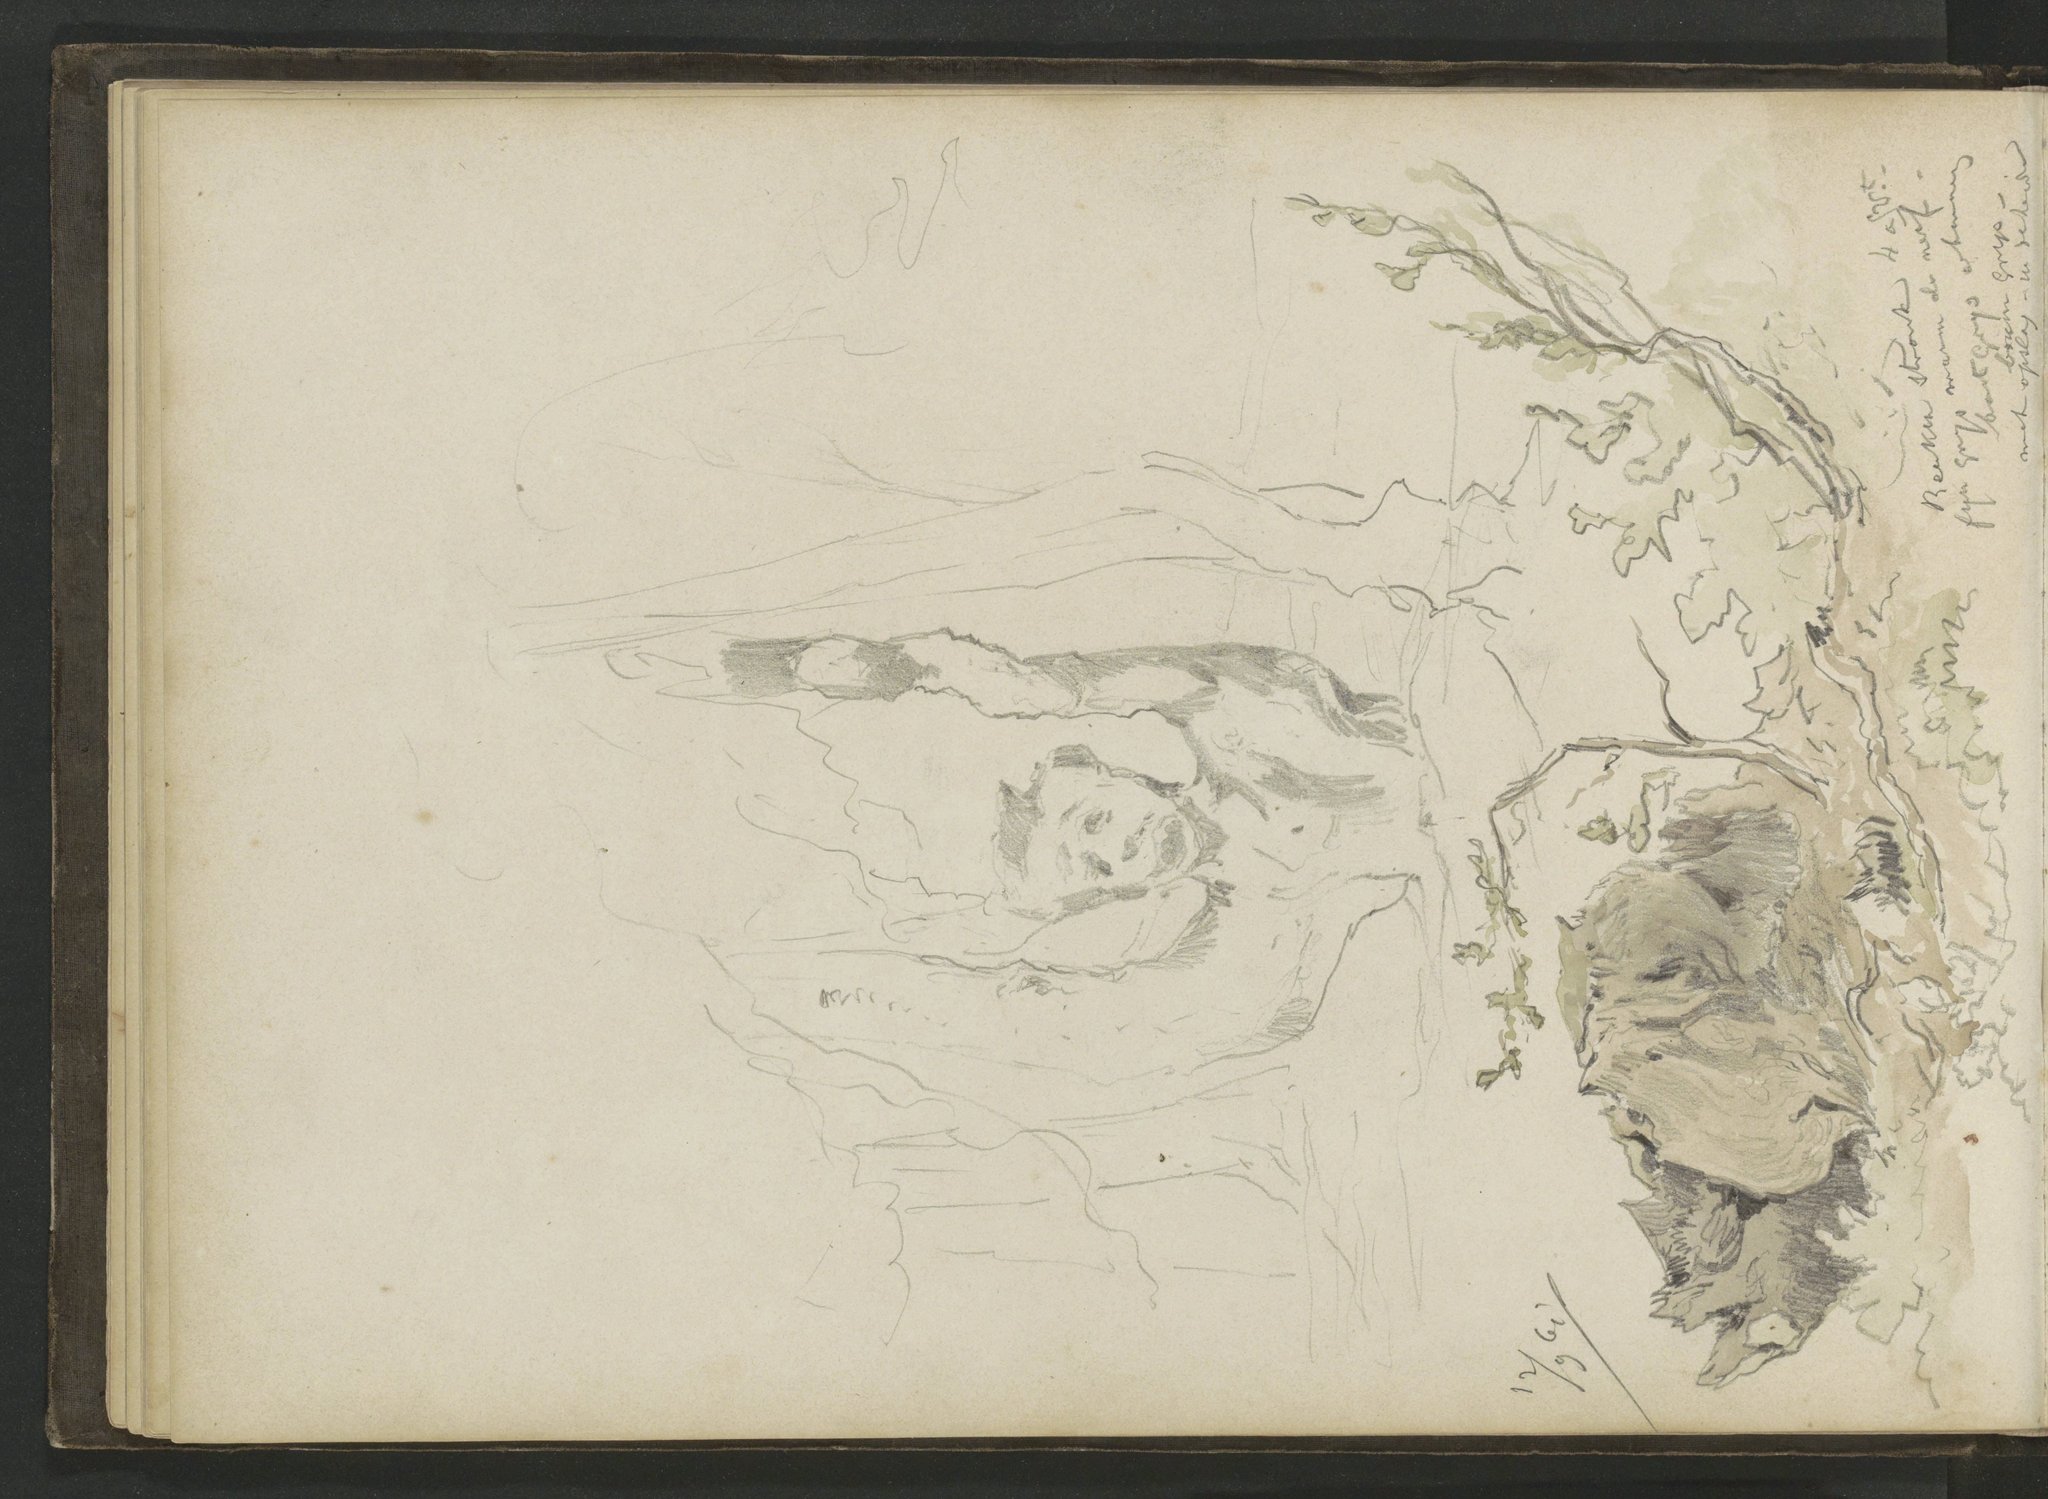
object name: sketchbook leaf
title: Stronken van beukenbomen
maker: johannes tavenraat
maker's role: draughtsman, painter, print maker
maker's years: 1809-1881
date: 1809-1861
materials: paper, pencil, watercolor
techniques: brush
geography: niederwald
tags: trees: beech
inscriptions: date: ‘12/9 61’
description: Blad 22 verso uit een schetsboek met 57 bladen.